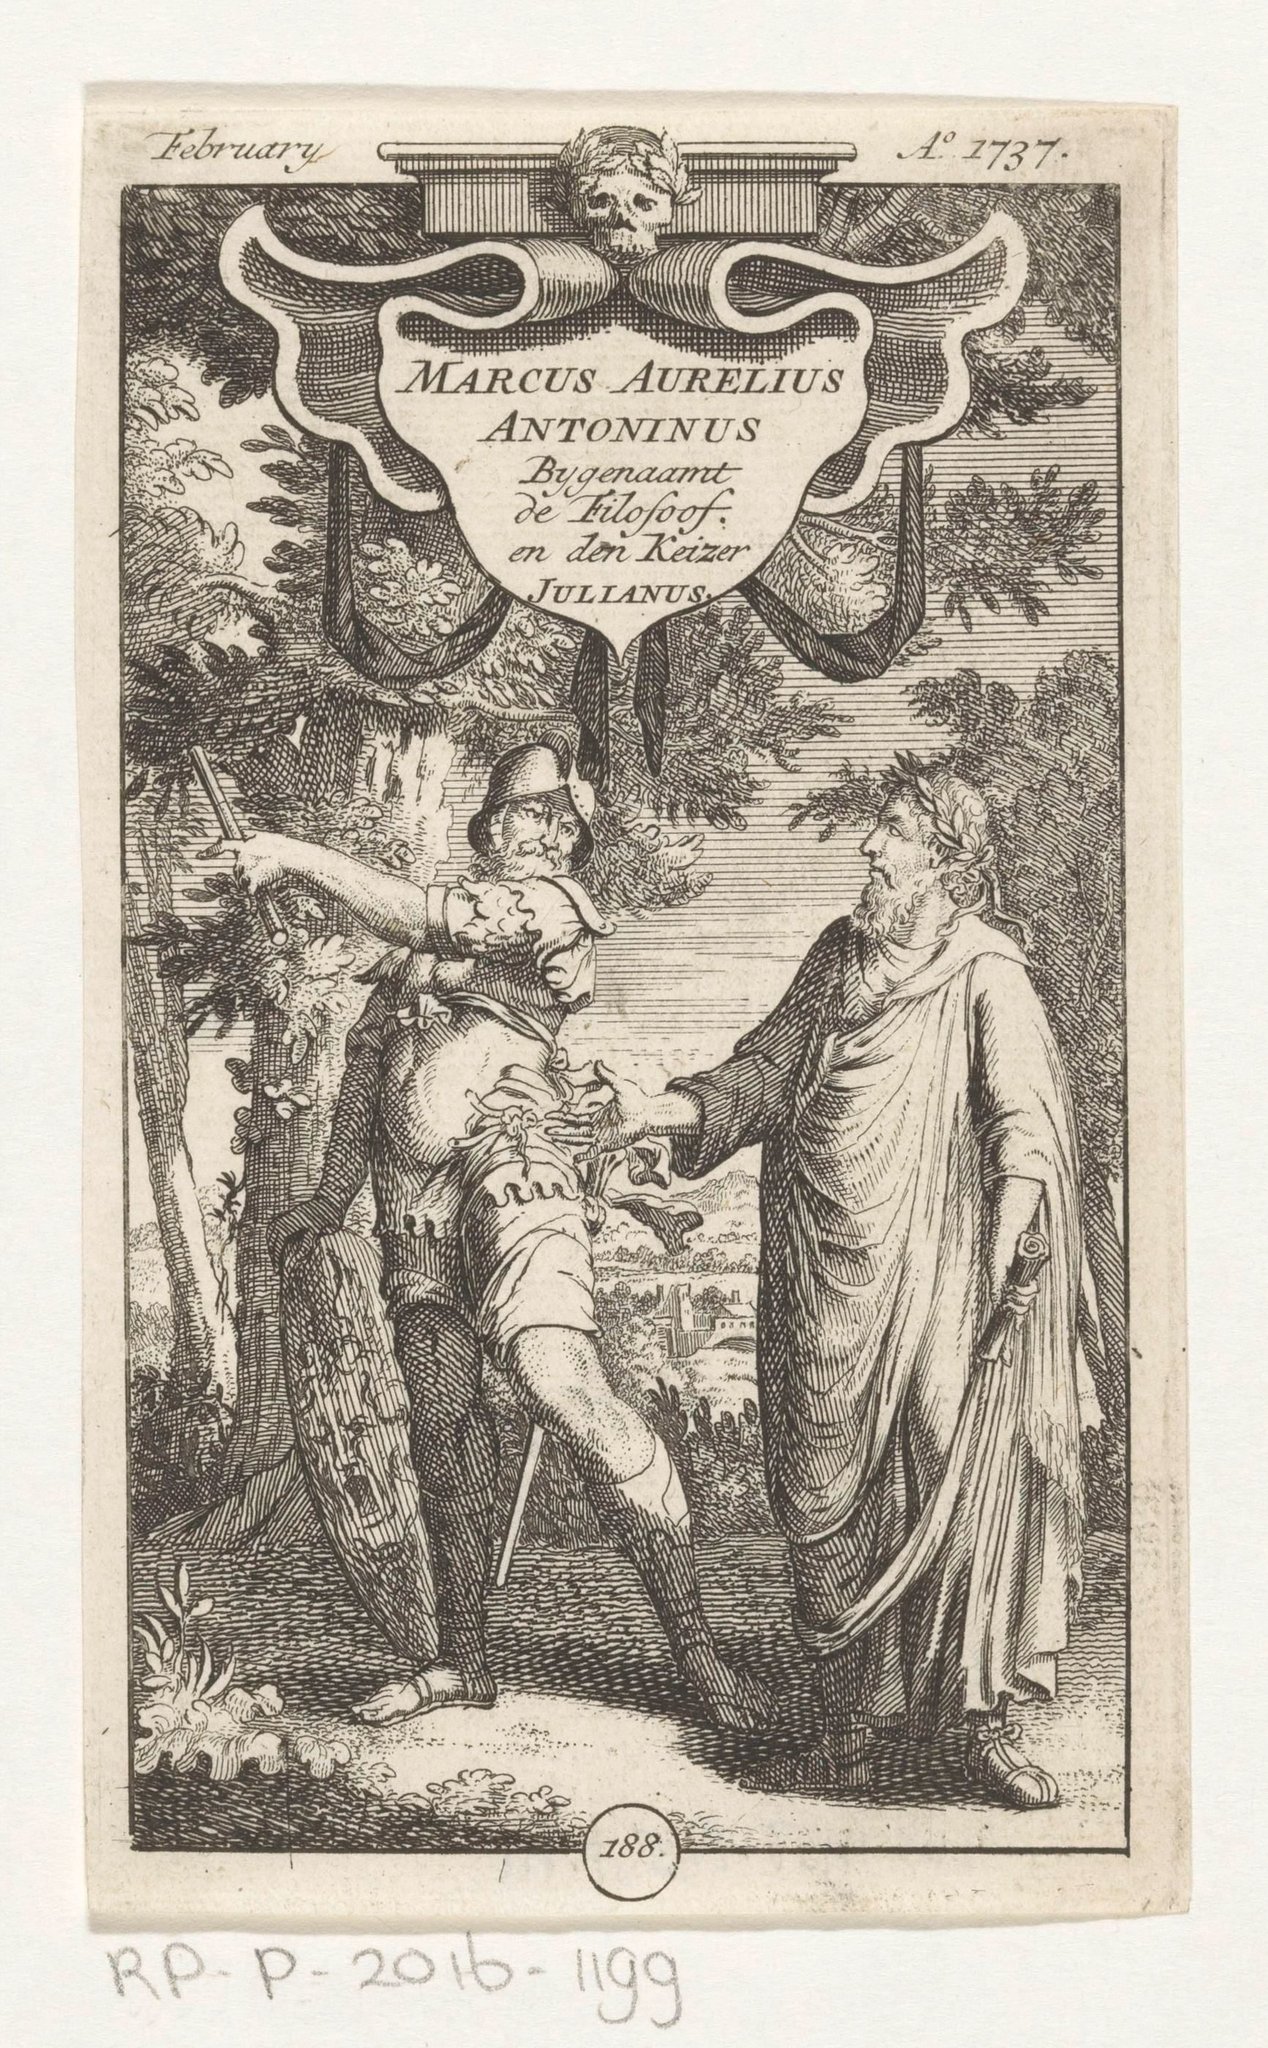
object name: book illustration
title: Gesprek tussen keizers Marcus Aurelius en Julianus de Afvallige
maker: Anonymous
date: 1702-1737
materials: paper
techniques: etching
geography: amsterdam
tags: conversation, dialogue; conversation piece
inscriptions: collector's mark: Lugt 2228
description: Prent uit het tijdschrift: S.n. Maandelyksche berichten uit de andere waerelt; of de spreekende dooden. Amsterdam: Ratelband, erven Johannes, februari 1737. Prent afkomstig uit een plakalbum met titelprenten, ornamenten etc. op blauw papier in 1983 uit elkaar gehaald. Volgens een notitie op verso zat de prent op p. 111 van dit album.